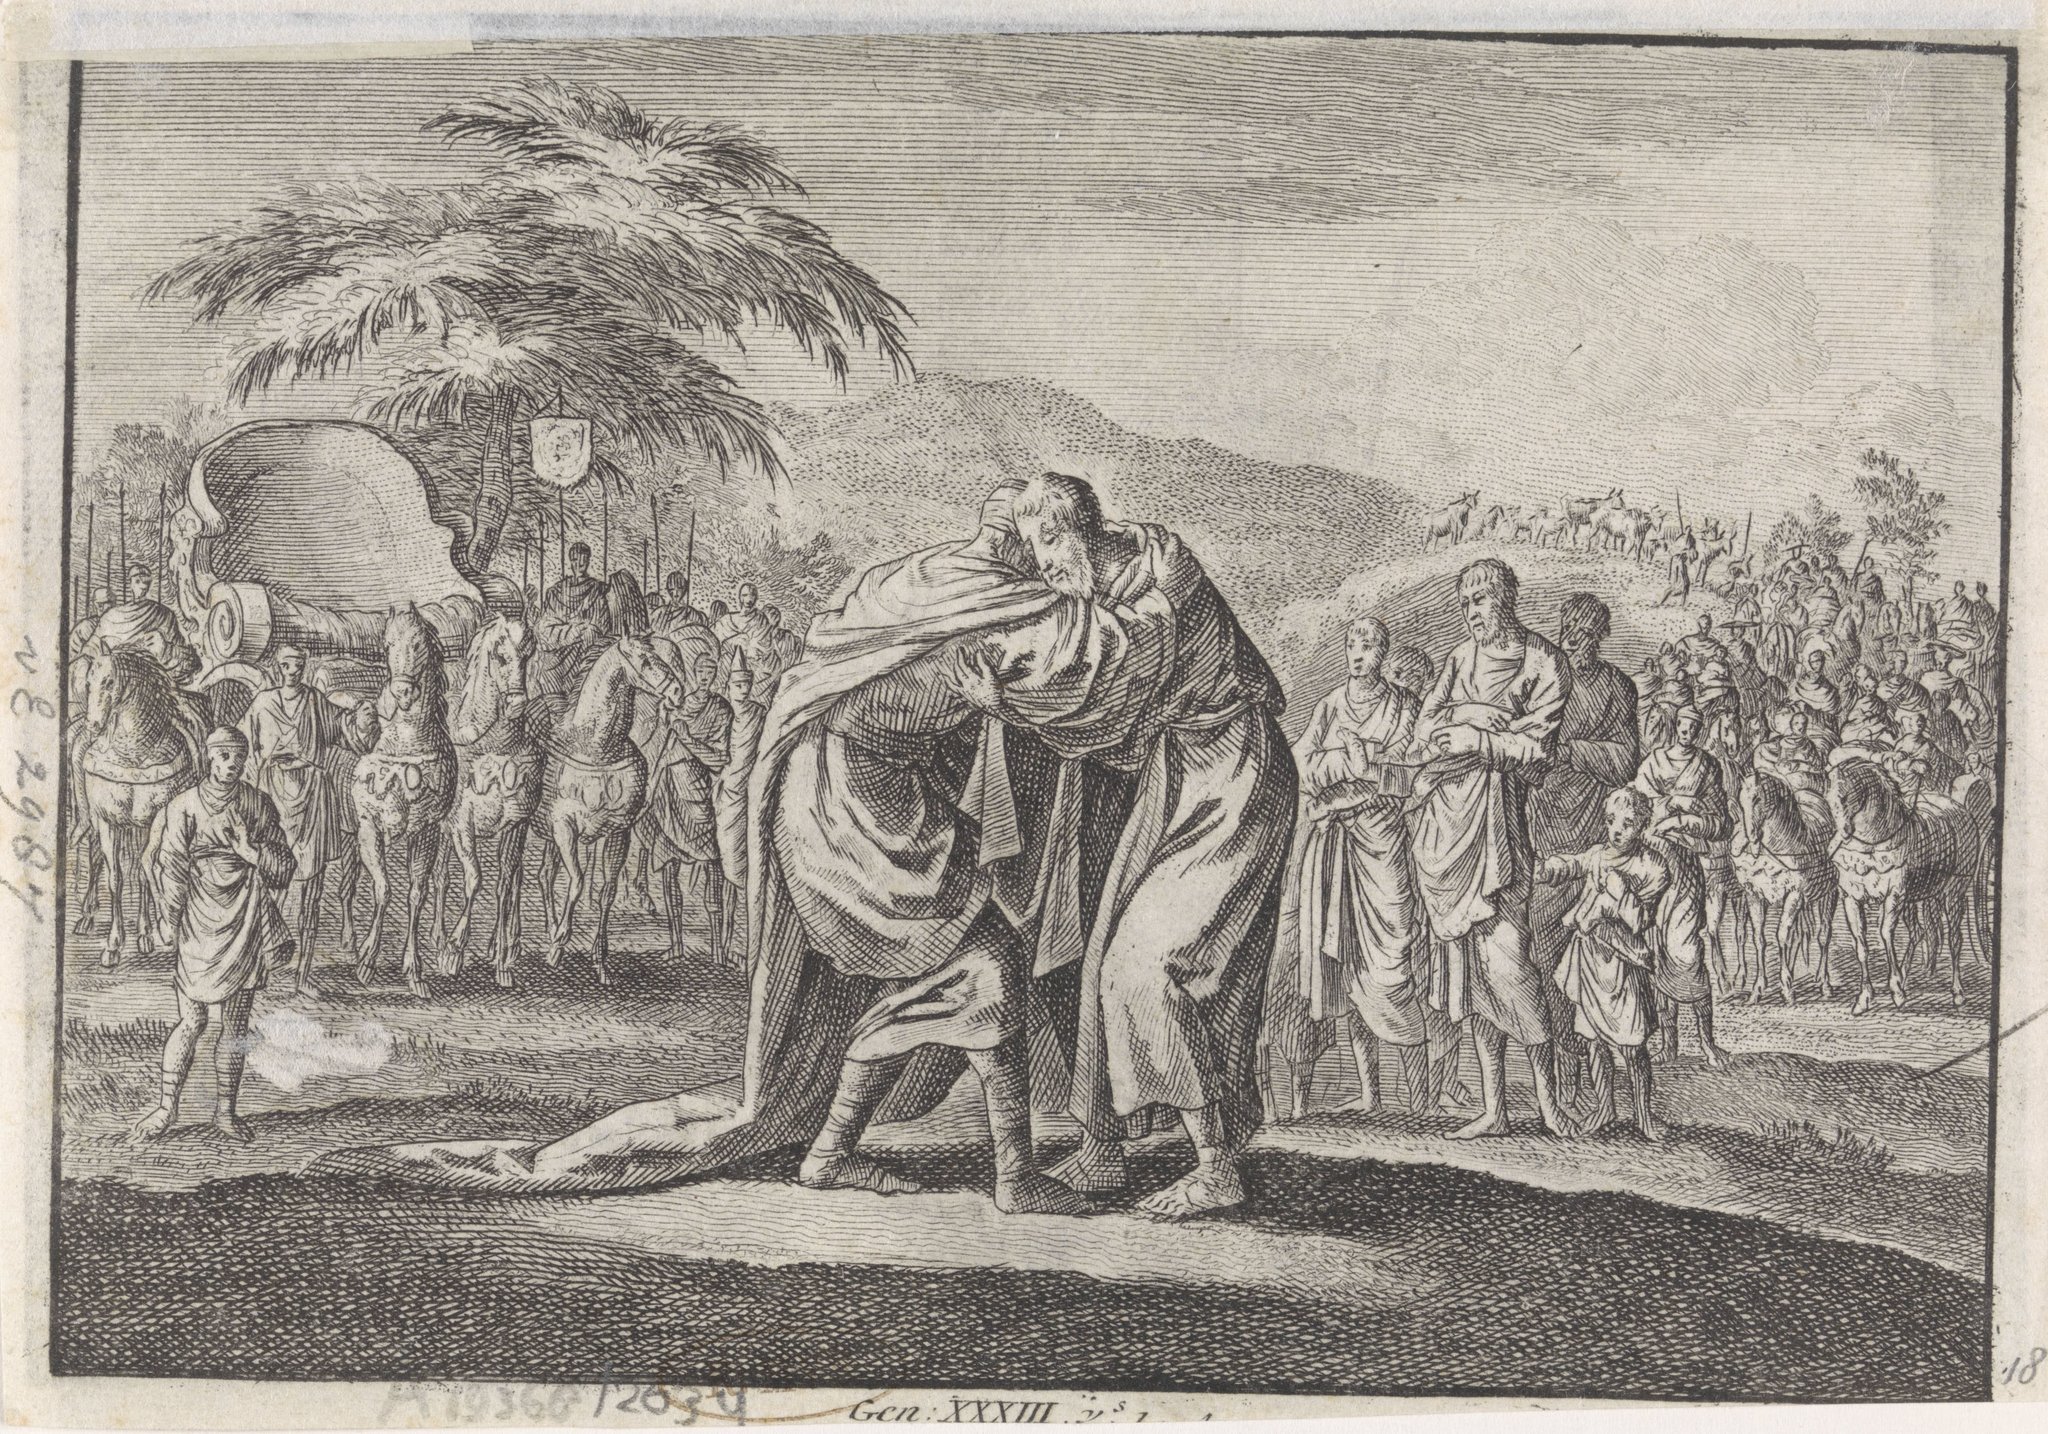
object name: print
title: Verzoening van Jakob en Esau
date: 1703-1762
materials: paper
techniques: etching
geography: amsterdam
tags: esau runs to meet jacob and kisses him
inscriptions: collector's mark: Lugt 2228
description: De prent komt een eerste keer voor als boekillustratie voor David Martin. Historie des Ouden en Nieuwen Testaments. Amsterdam, Pieter Mortier, 1703. Deel I. De boekillustraties voor de Mortierbijbel hebben verschillende staten en kopieën, waarbij de chronologische volgorde moeilijk te achterhalen valt. Als boekillustraties werden ze bovendien herhaaldelijk opnieuw gebruikt voor andere boekwerken.